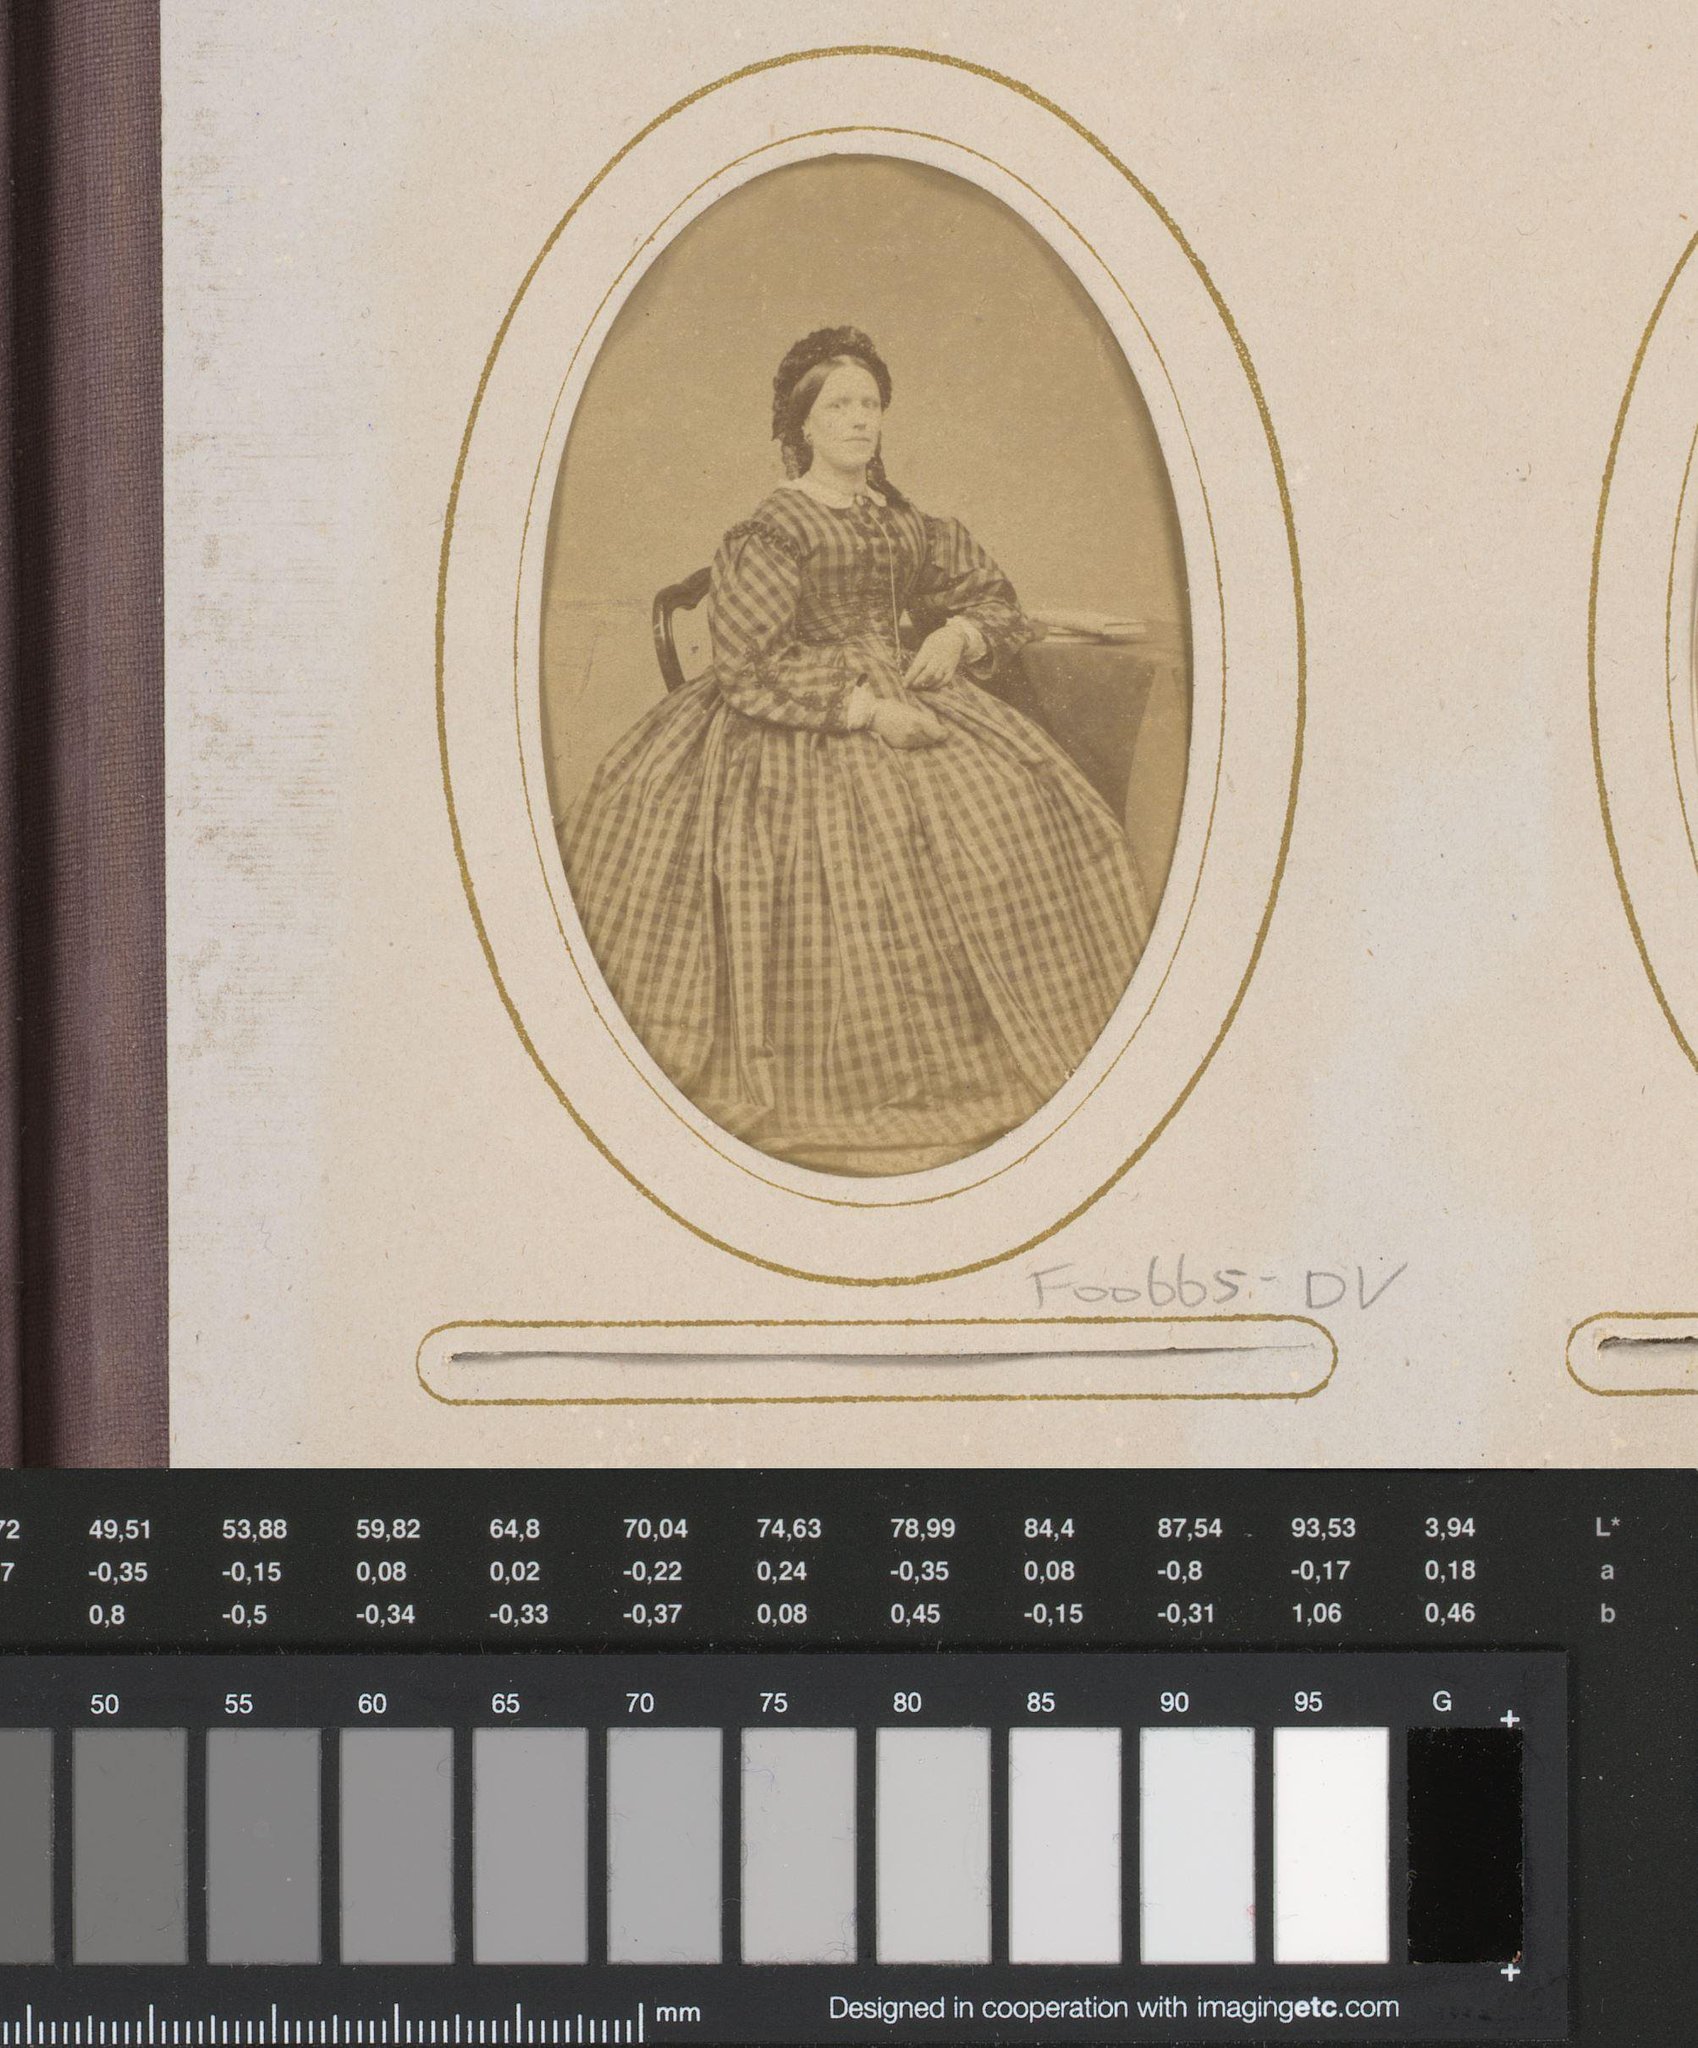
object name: album leaf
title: Portret van een vrouw met muts in geruite japon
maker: johannes hinderikus egenberger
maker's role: draughtsman, print maker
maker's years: 1822-1897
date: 1864-1880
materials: cardboard, photographic support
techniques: albumen print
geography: netherlands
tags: historical persons - bb - woman, head-gear: cap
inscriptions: inscription: ‘J.H. Egenberger/ Groningen/ Leeuwarden’